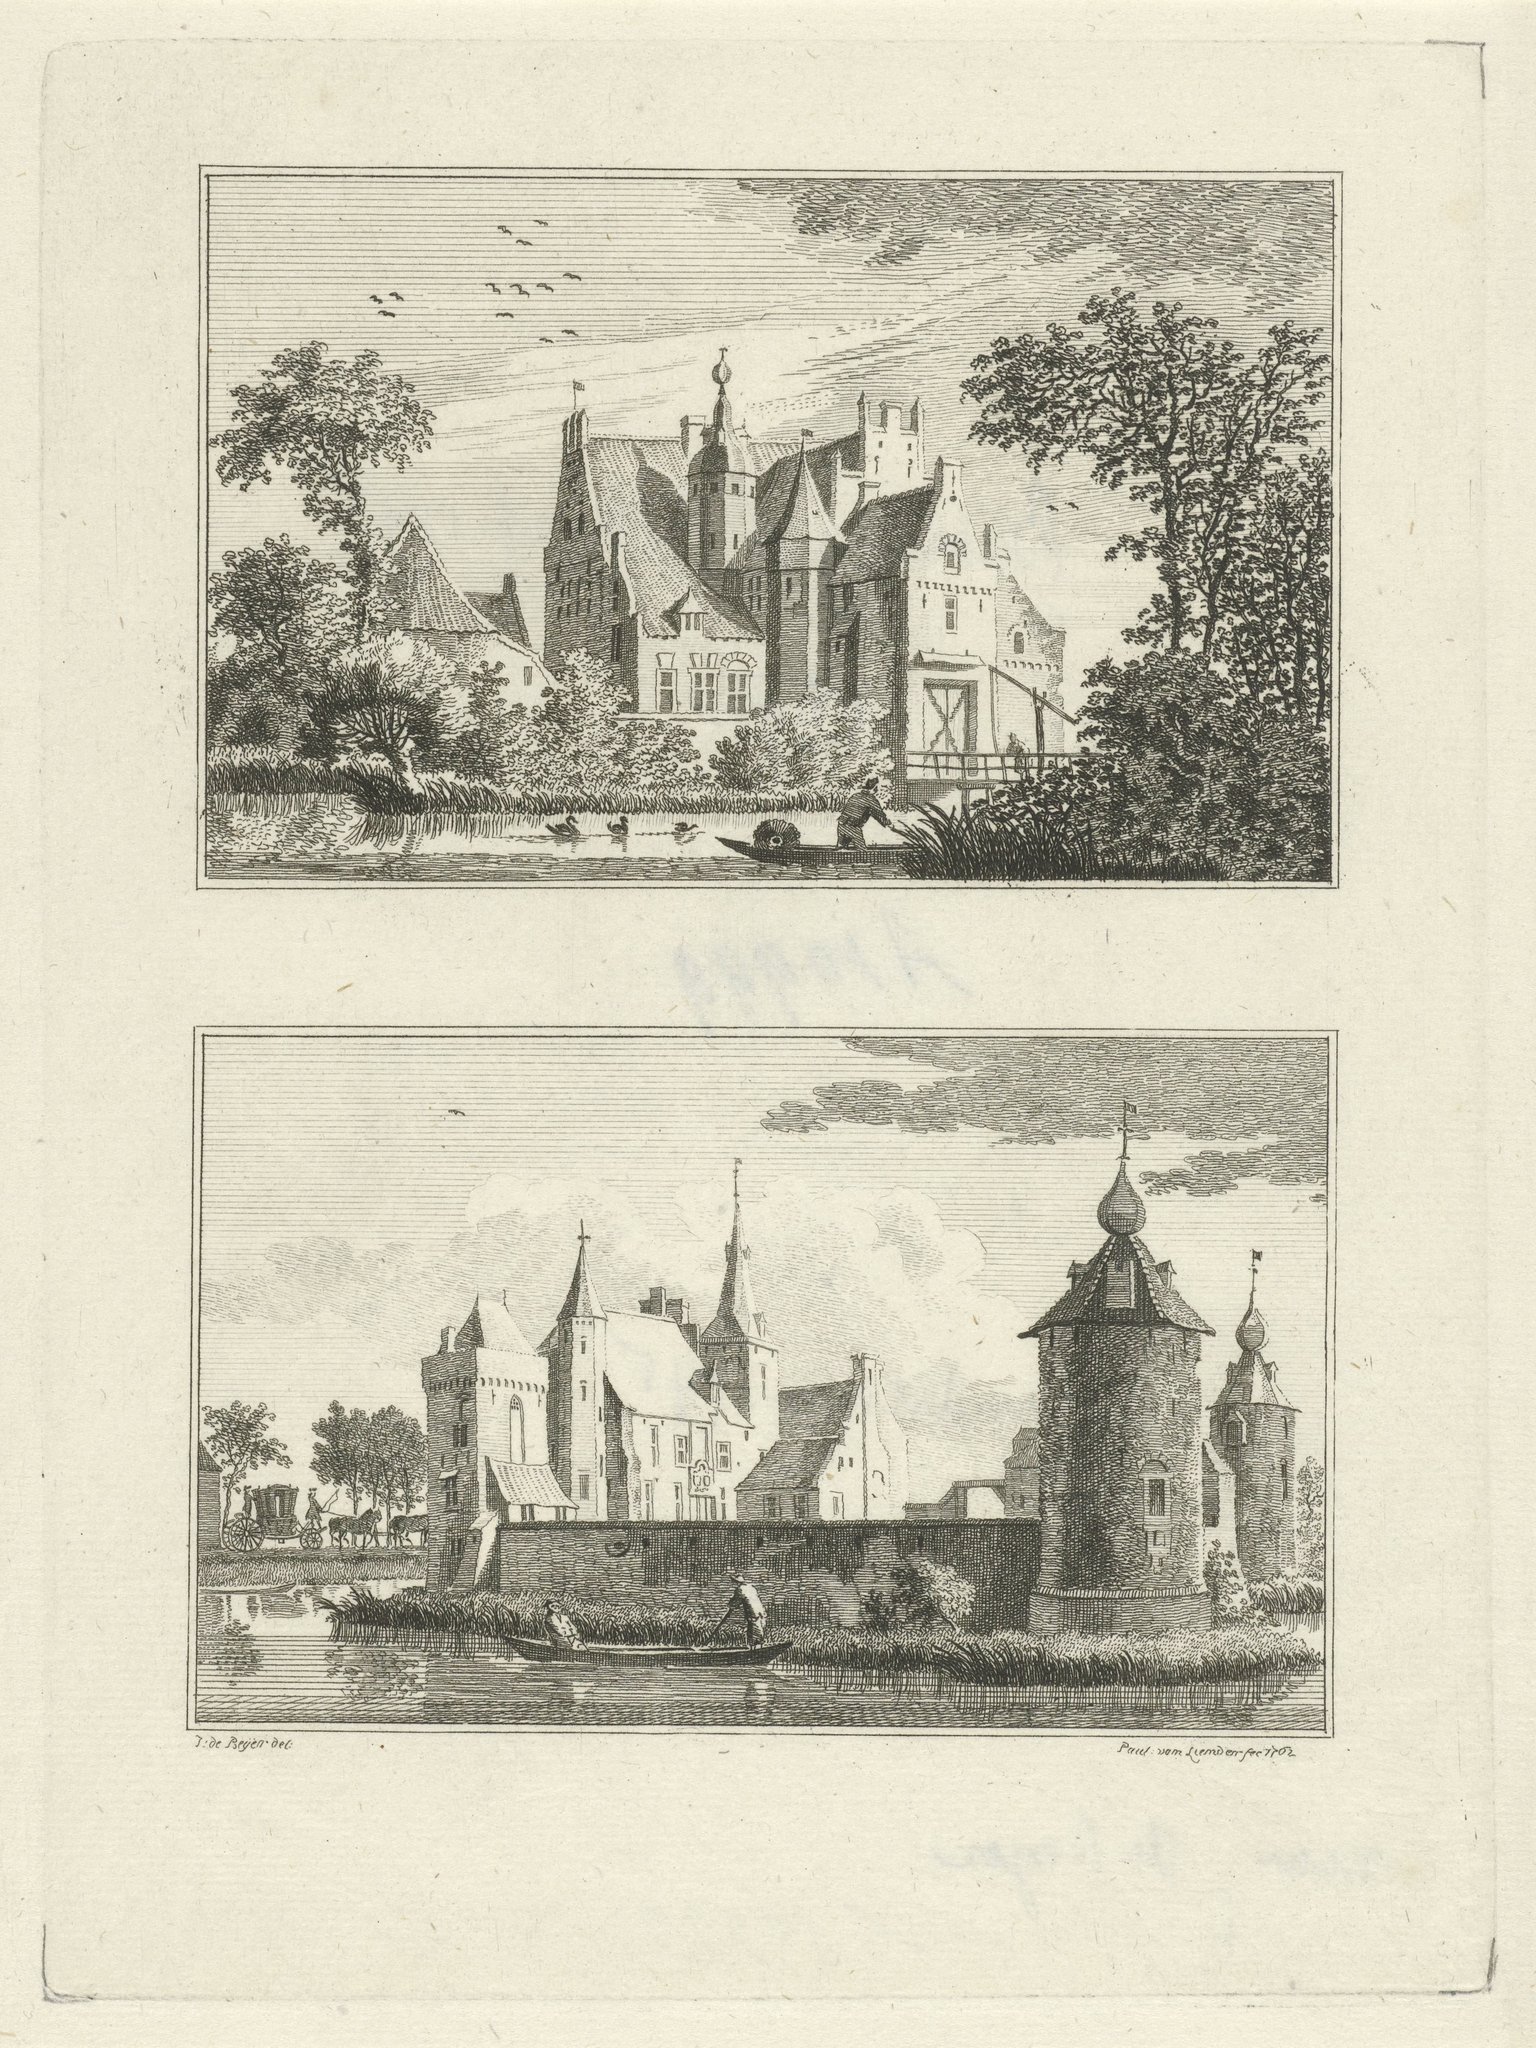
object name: print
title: Kasteel Halsaf en Kasteel Grondstein, 1745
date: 1762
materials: paper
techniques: etching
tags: castle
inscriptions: collector's mark: Lugt 2228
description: Twee voorstellingen van één plaat. Gezicht op Kasteel Halsaf in Babberich (boven) en Kasteel Grondstein bij het Duitse dorp Elten (onder). De prent maakt deel uit van een 100-delige serie met gezichten op dorpen en steden te Kleef.